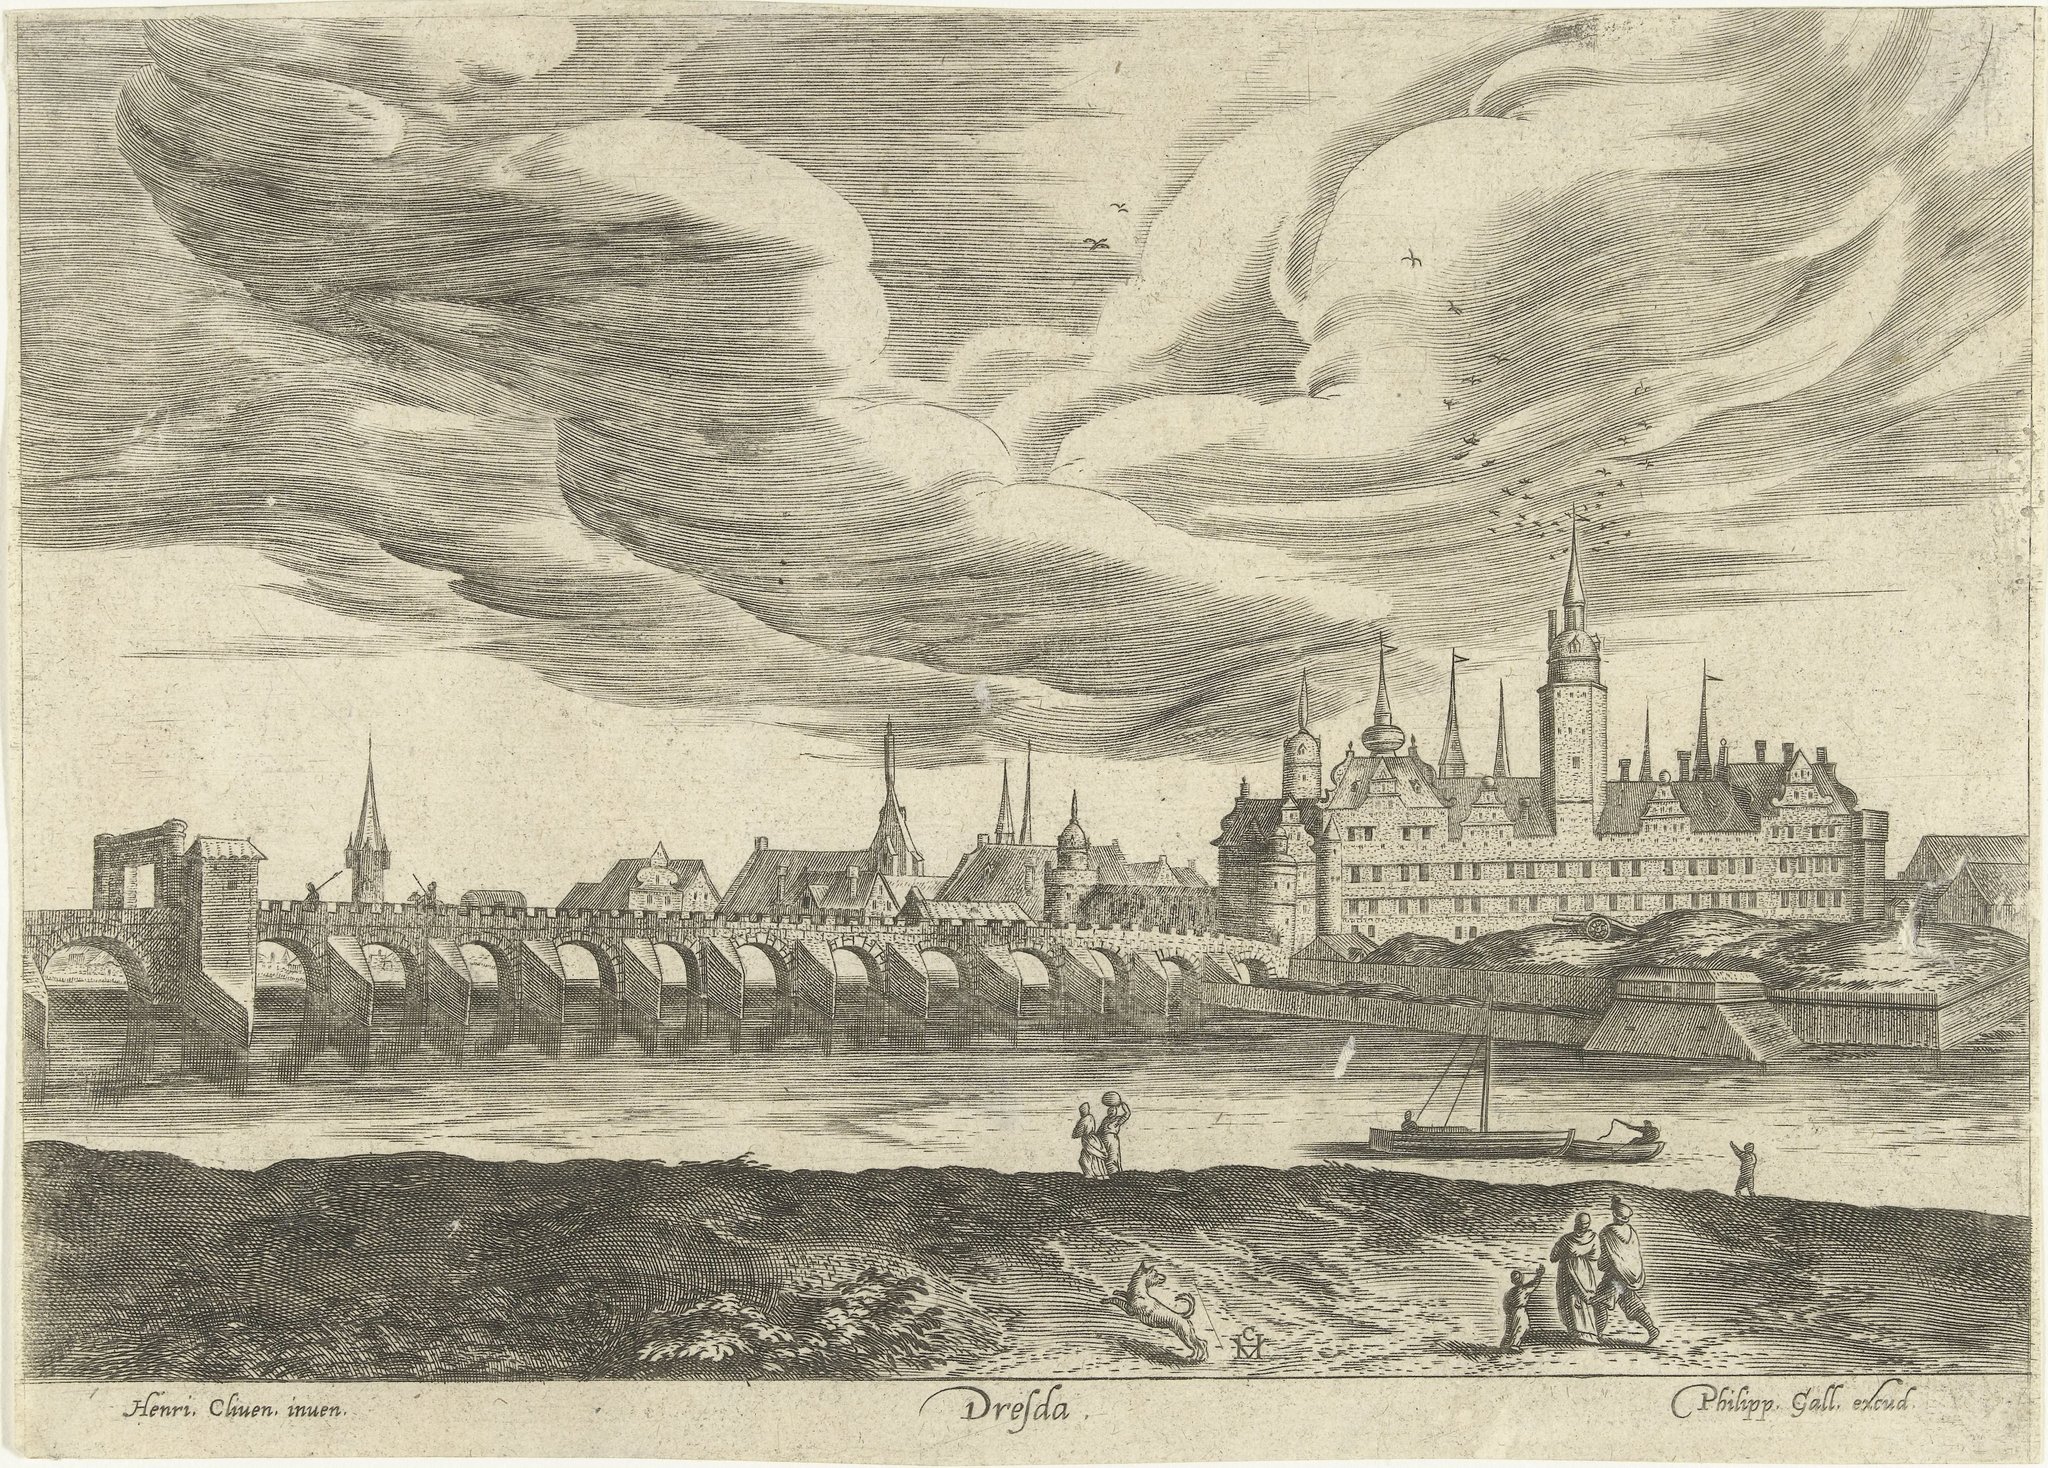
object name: print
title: Gezicht op Dresden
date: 1585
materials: paper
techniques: engraving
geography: antwerp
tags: city-view, and landscape with man-made constructions (+ city(-scape) with figures, staffage)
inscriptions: collector's mark: Lugt 2228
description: Gezicht op de stad Dresden. Op de voorgrond de brug over de Elbe en wandelaars. De prent is deel van een serie die verschillende plaatsen in het Middellandse Zeegebied afbeeldt.